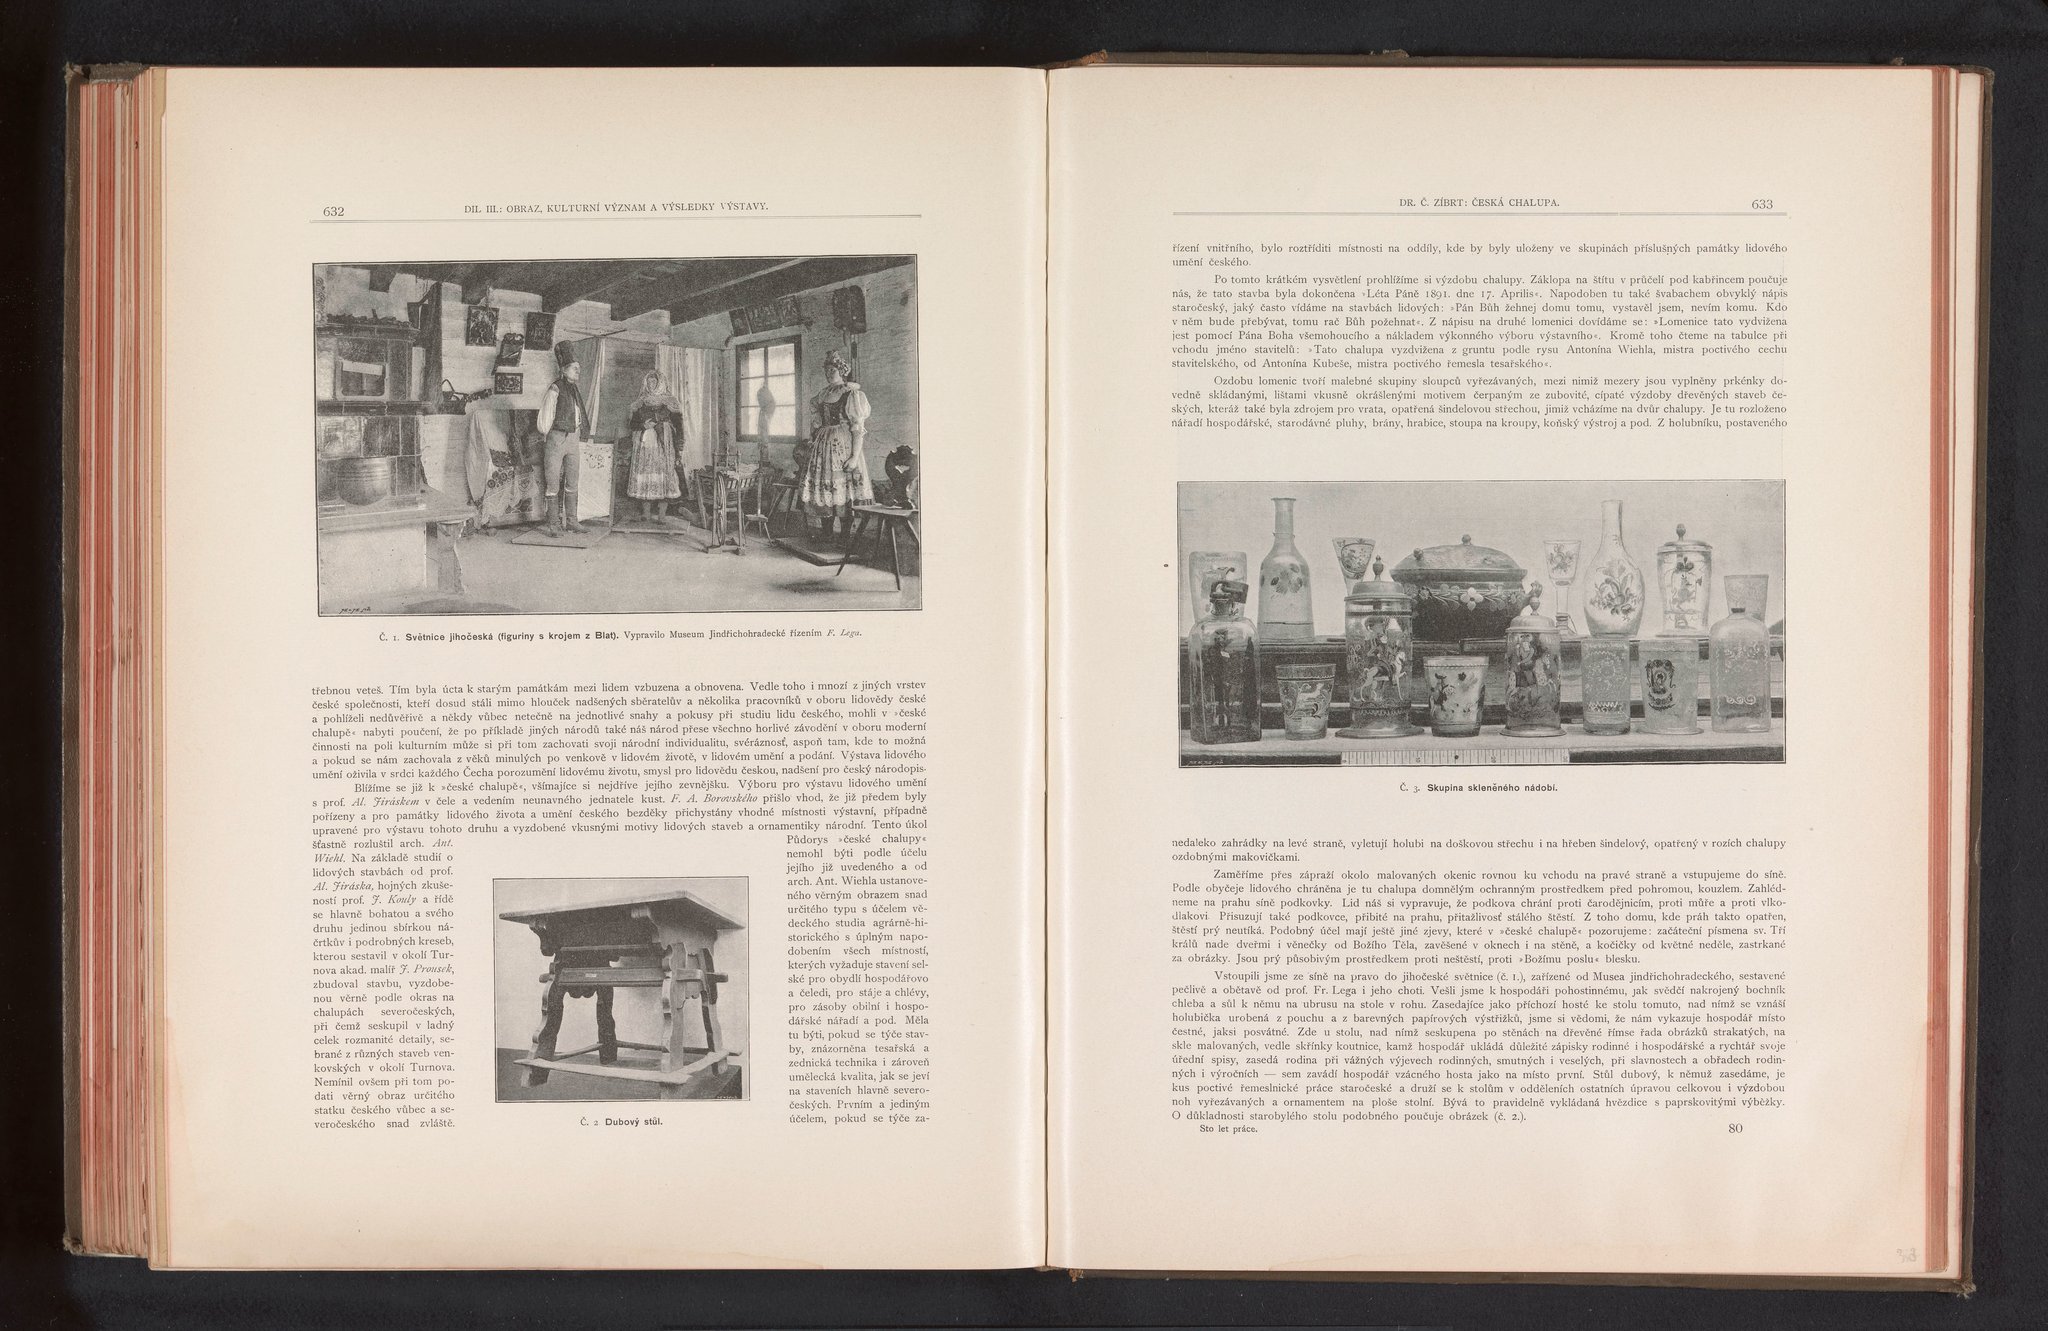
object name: photomechanical print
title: Skupina skleneného nádobi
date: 1891-1895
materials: paper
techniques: autotype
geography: prague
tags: container of glass: bottle, jar, vase